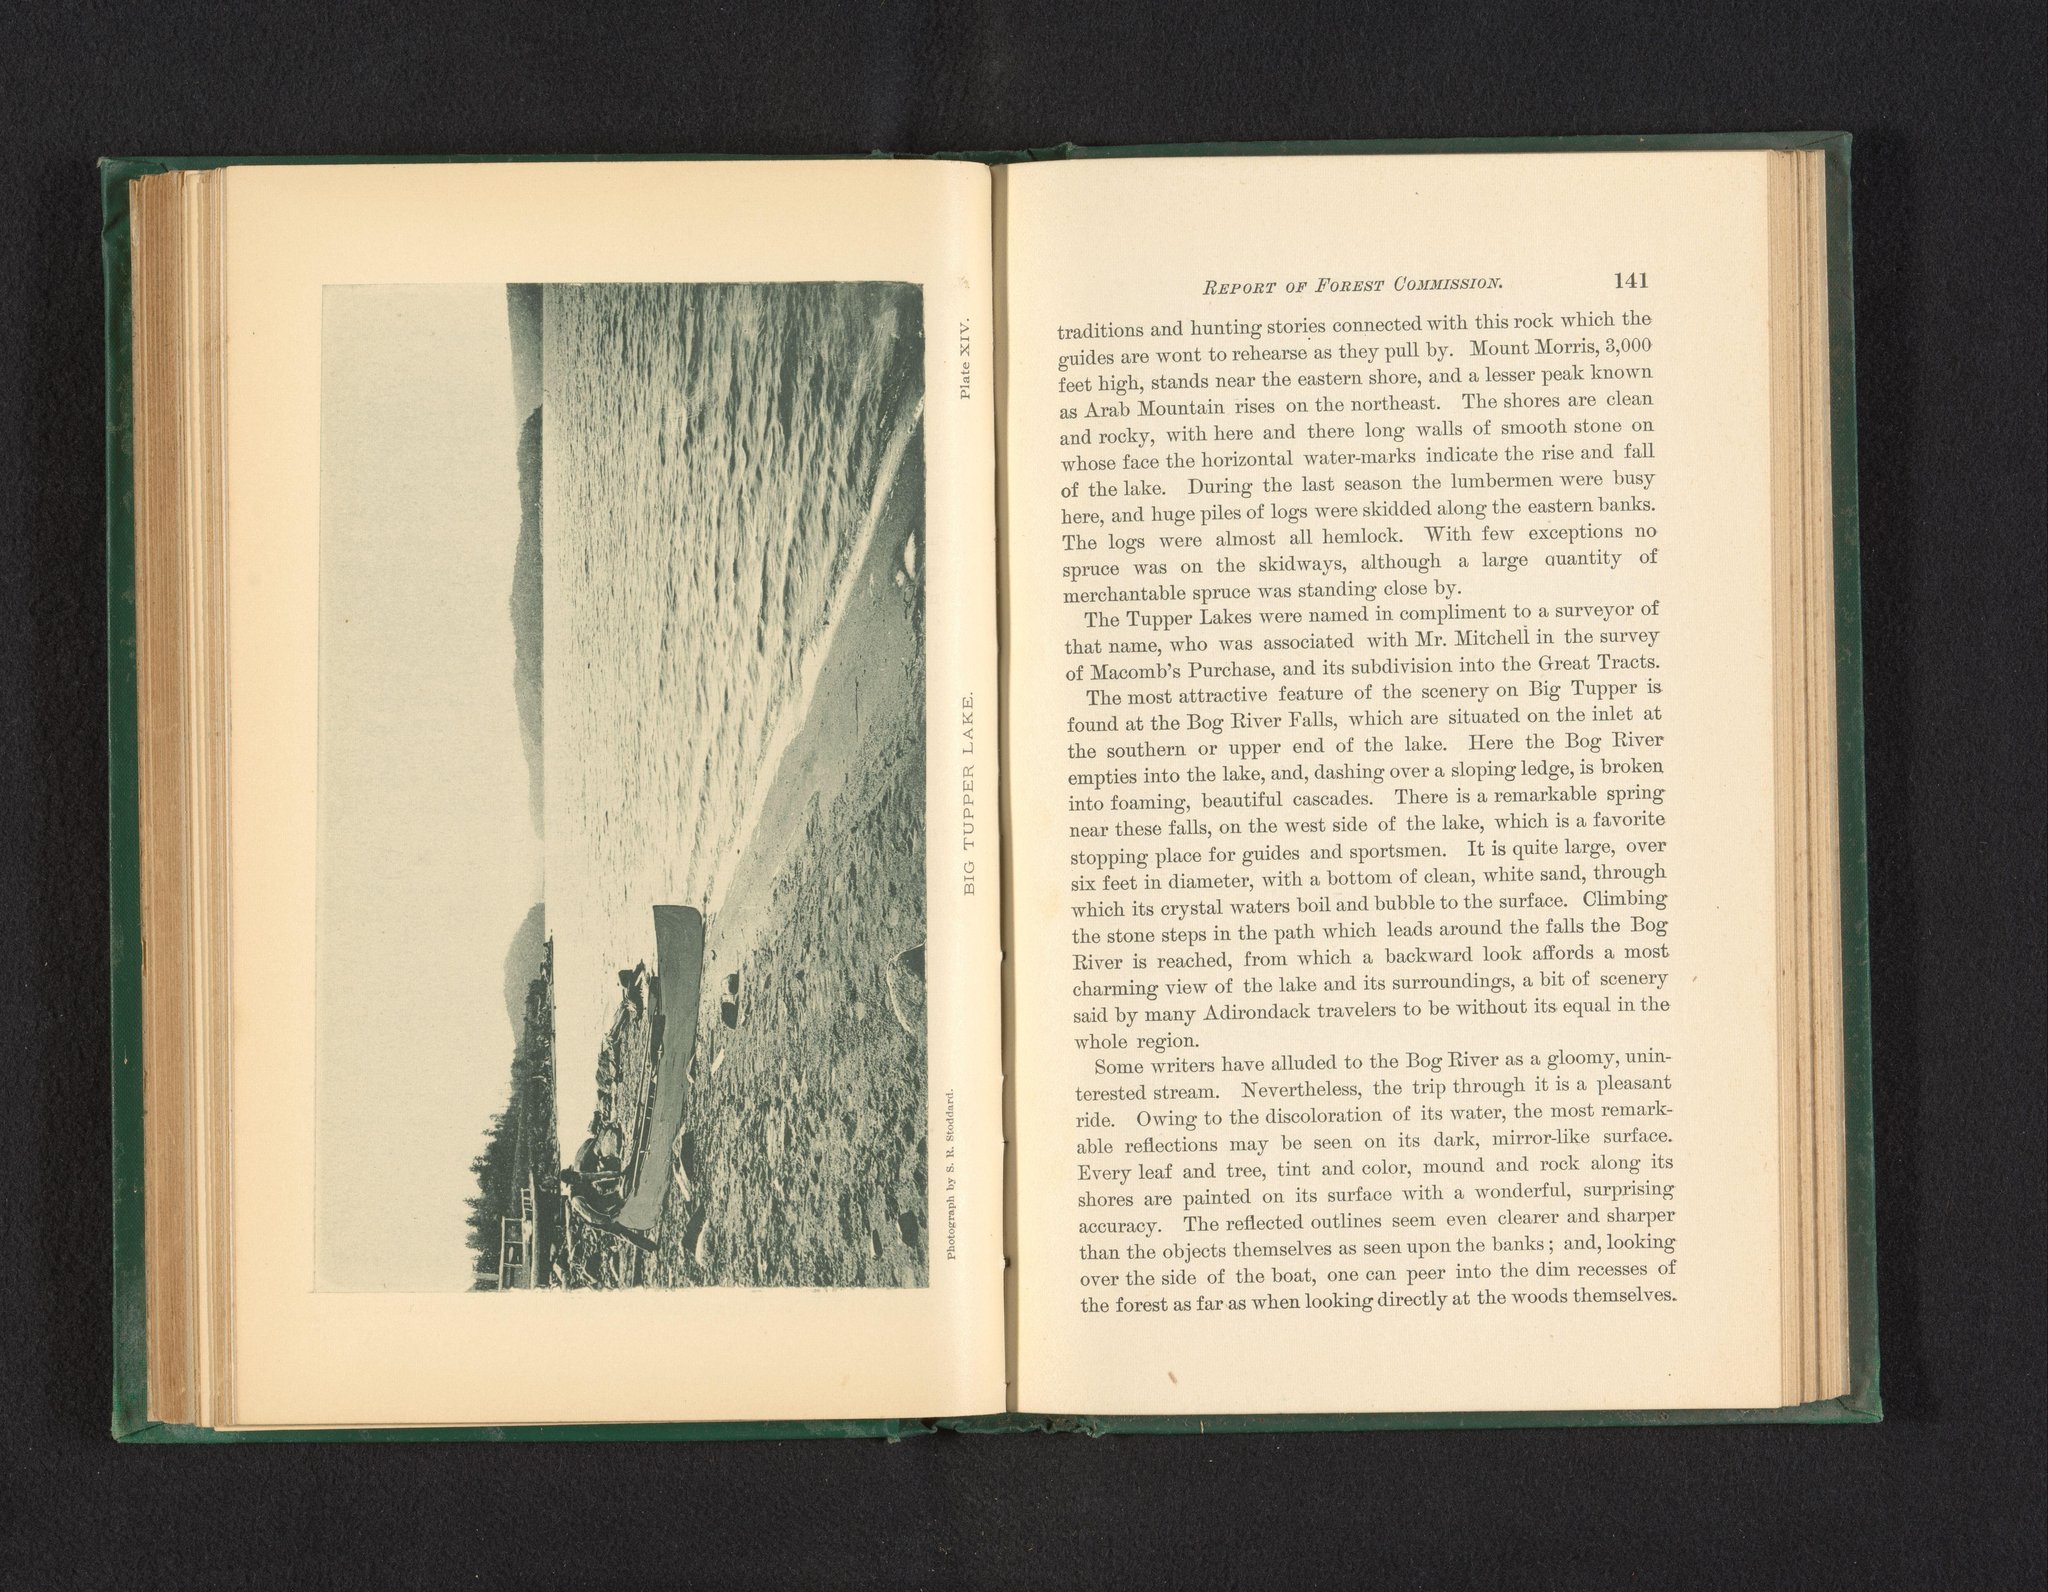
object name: page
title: Big Tupper Lake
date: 1891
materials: paper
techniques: photograph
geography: new york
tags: lake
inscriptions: number: ‘Plate XIV.’